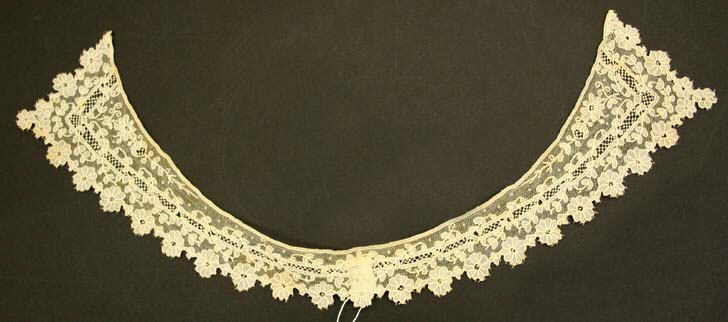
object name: collar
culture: european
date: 1861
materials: cotton